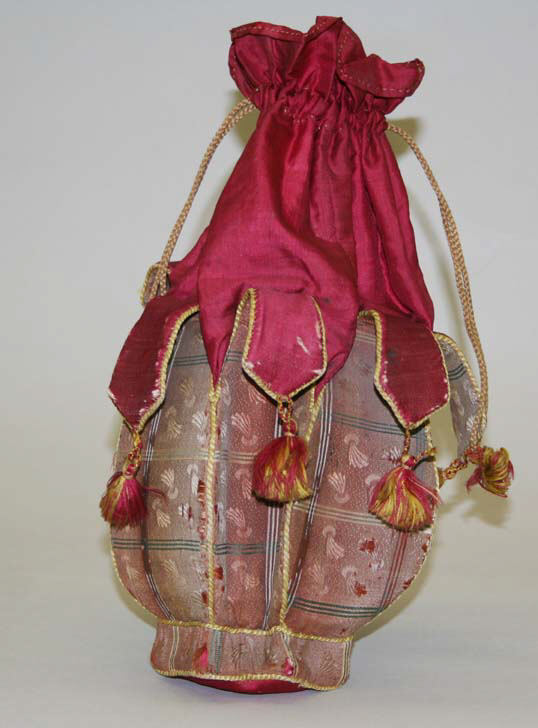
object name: bag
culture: italian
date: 1860-1870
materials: silk